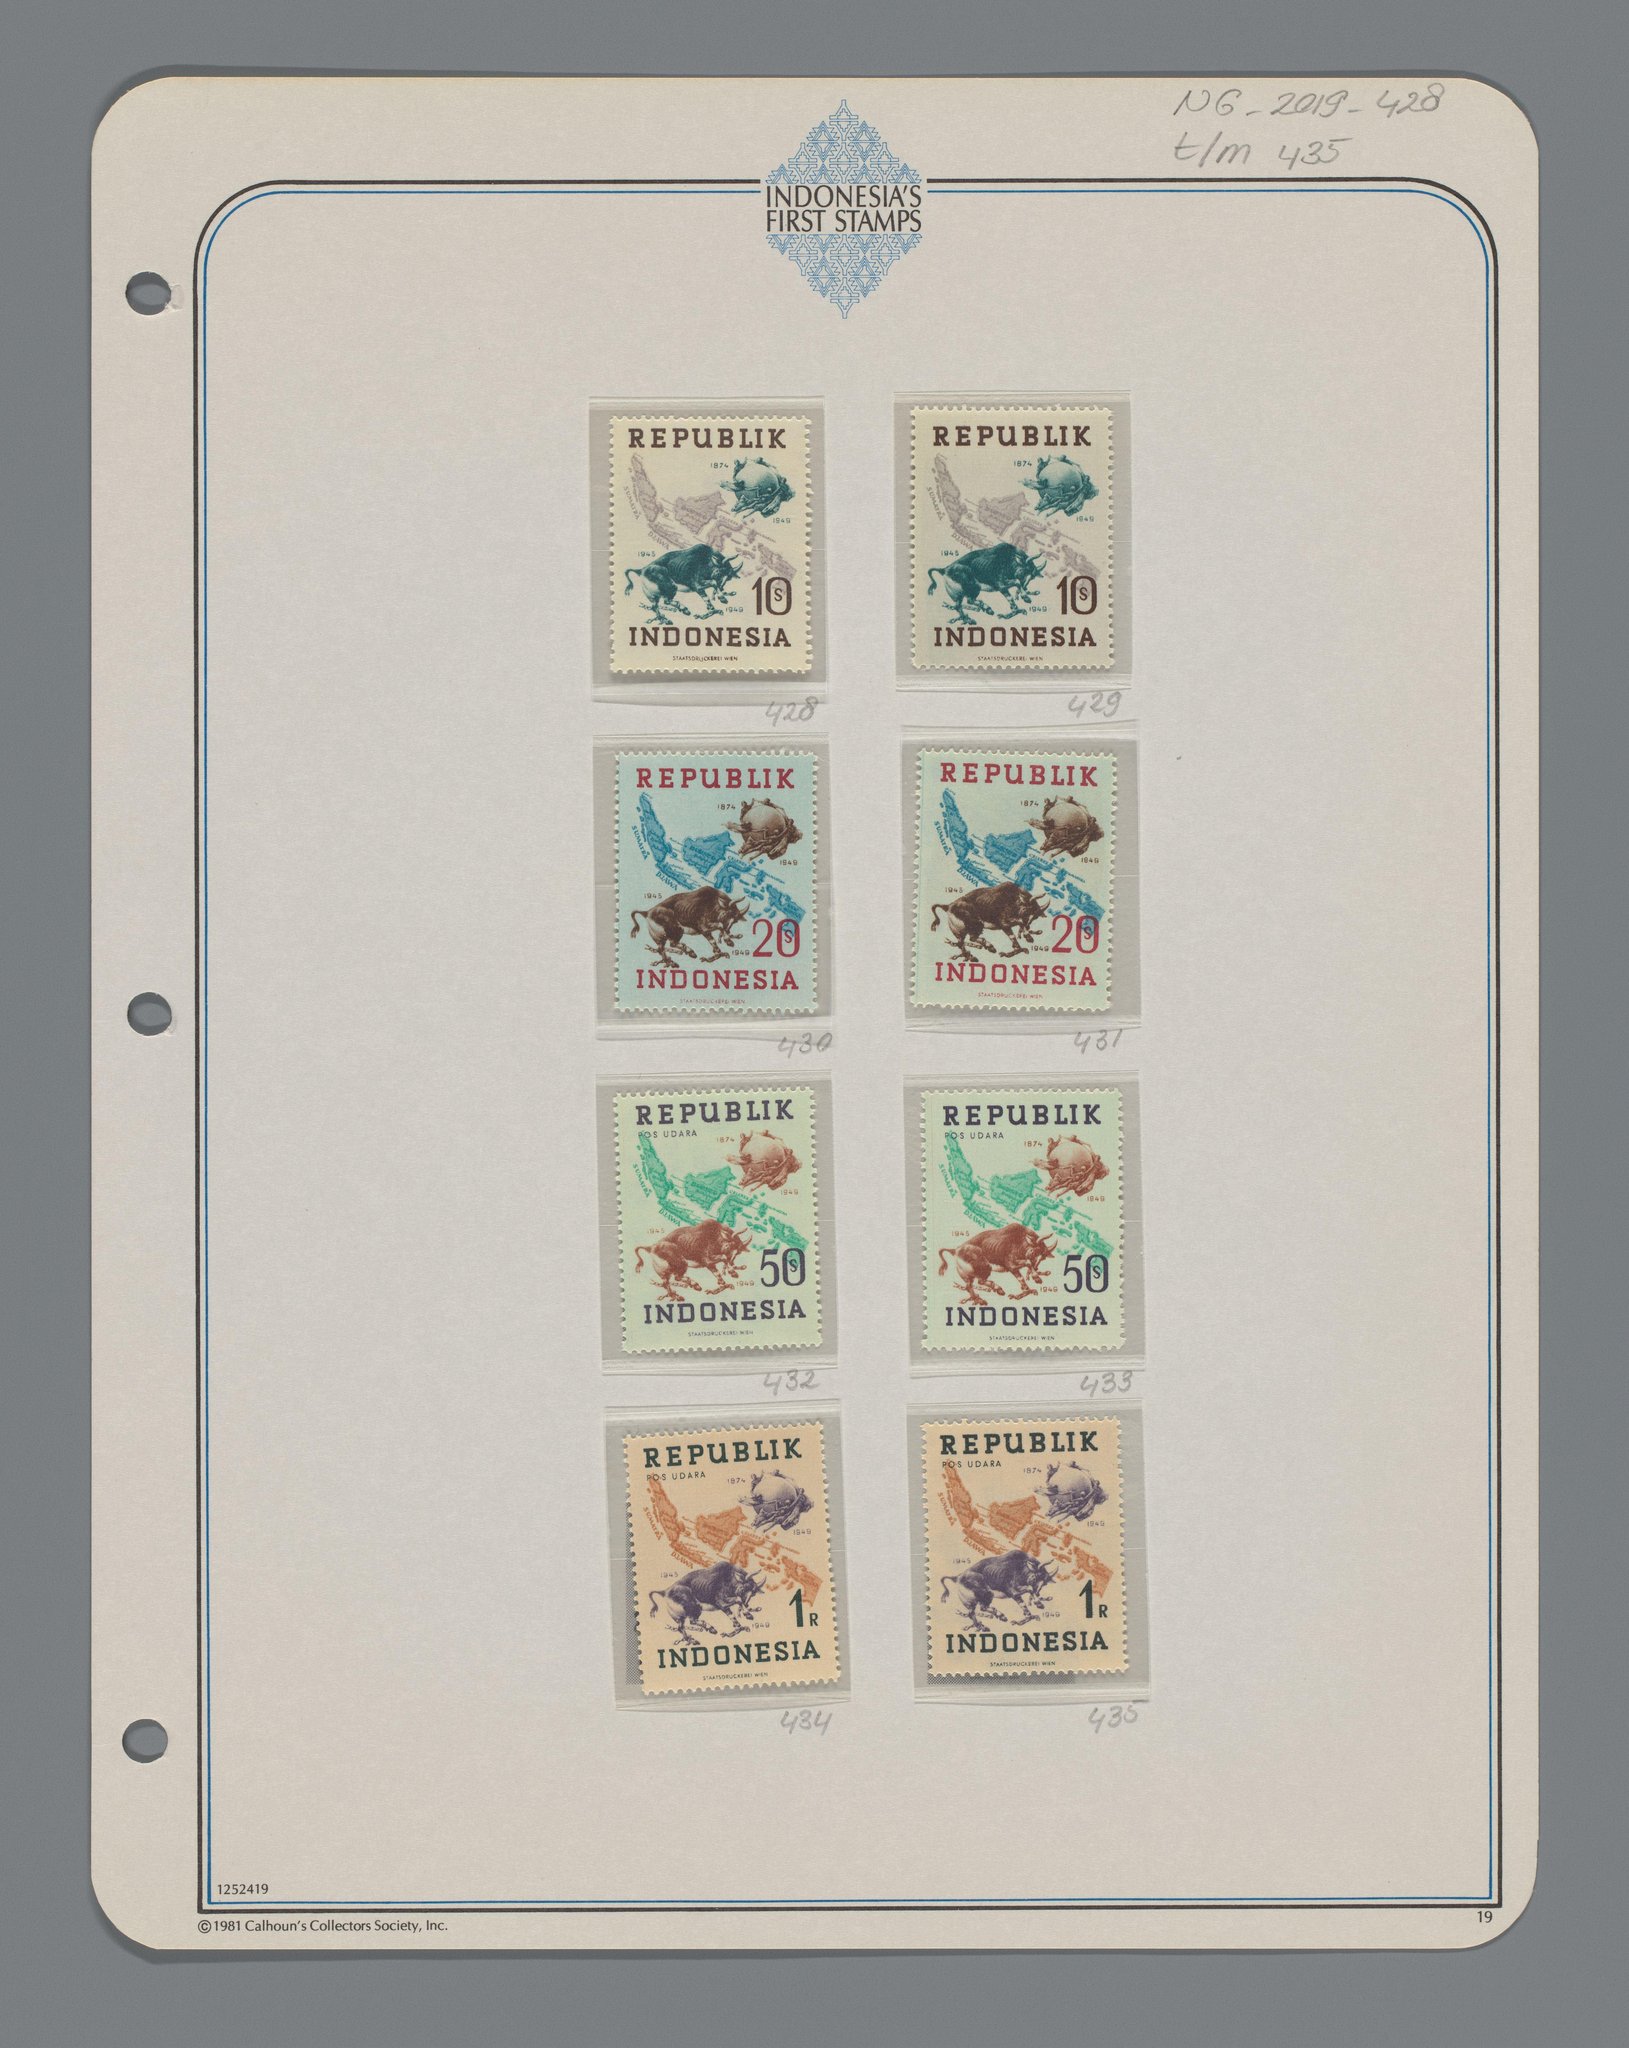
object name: postage stamp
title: Postzegel Republik Indonesia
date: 1949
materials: paper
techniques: photoaquatint, engraving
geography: philadelphia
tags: indonesia